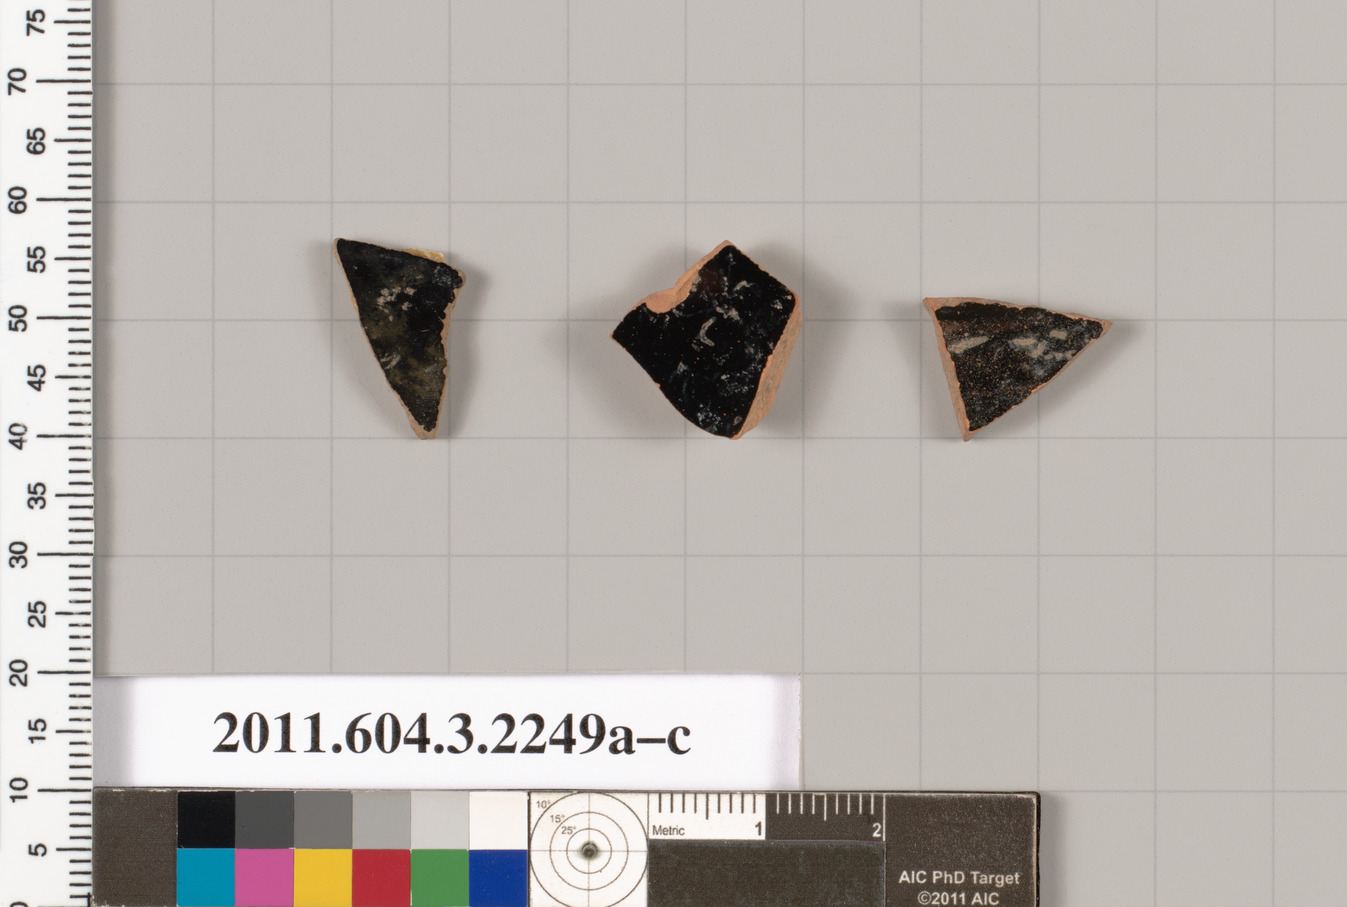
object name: kylix fragment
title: Terracotta fragments of kylikes (drinking cups)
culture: greek, attic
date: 600-401 BCE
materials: terracotta